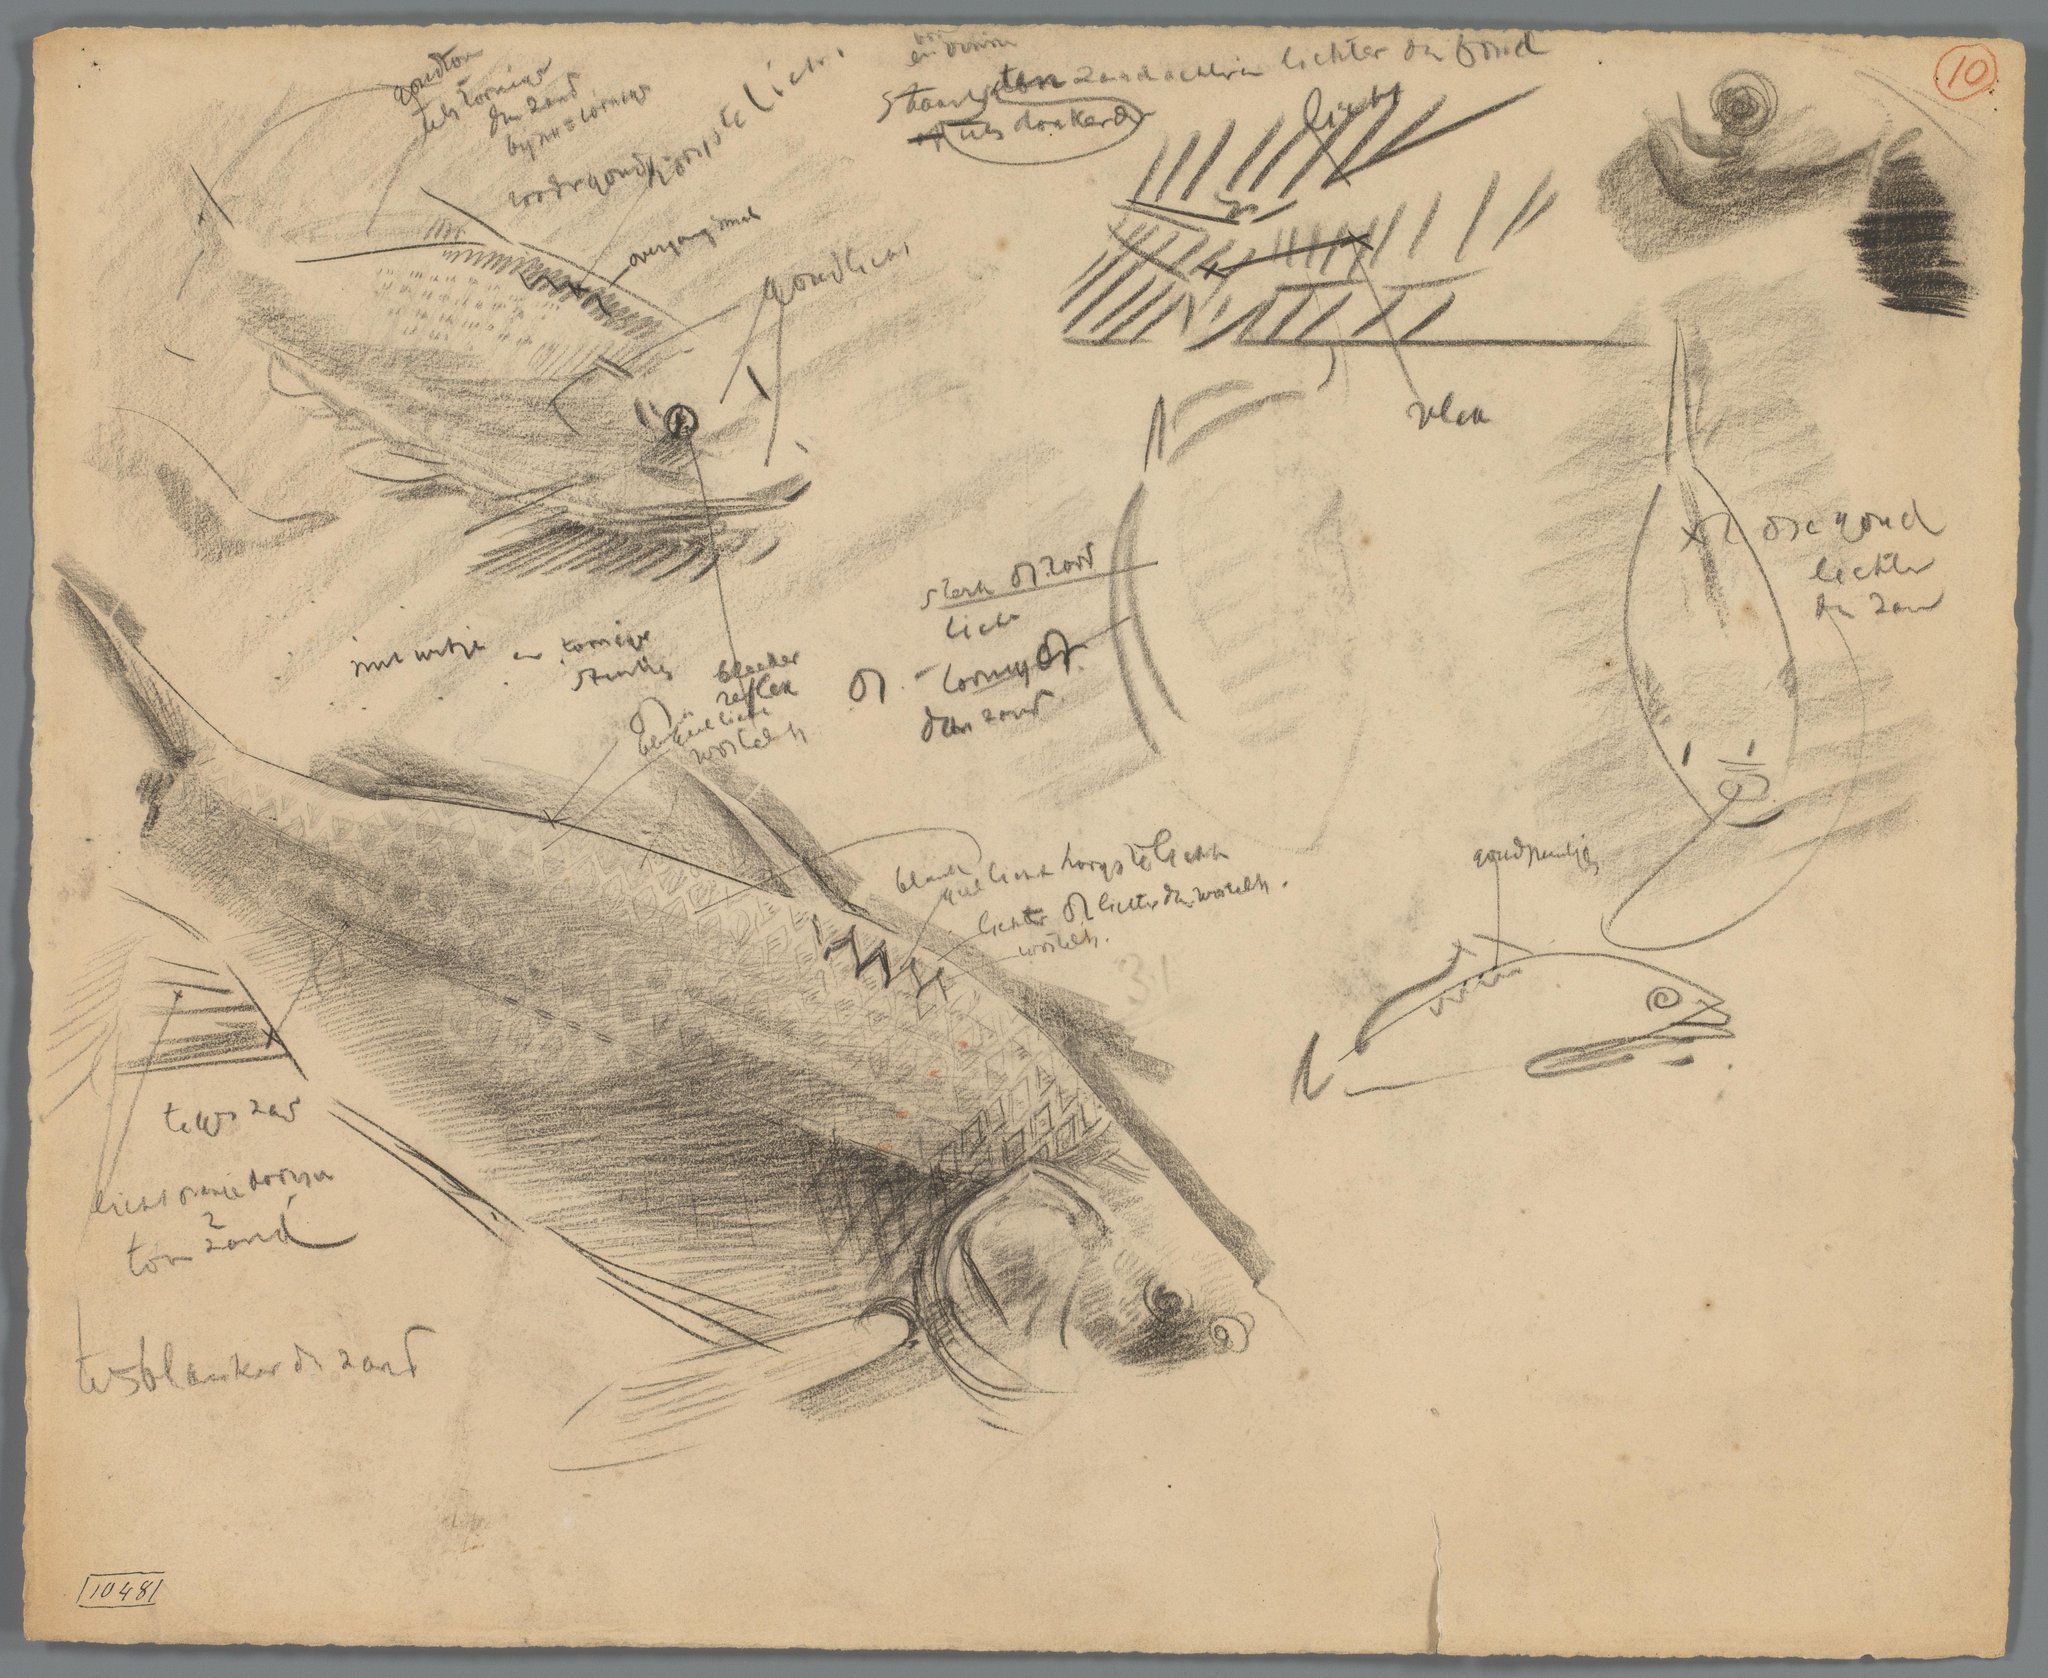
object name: drawing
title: Studies van karpers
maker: gerrit willem dijsselhof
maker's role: designer, draughtsman, print maker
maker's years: 1866-1924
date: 1876-1924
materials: chalk, paper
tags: bony fishes: carp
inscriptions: number: ‘1048’